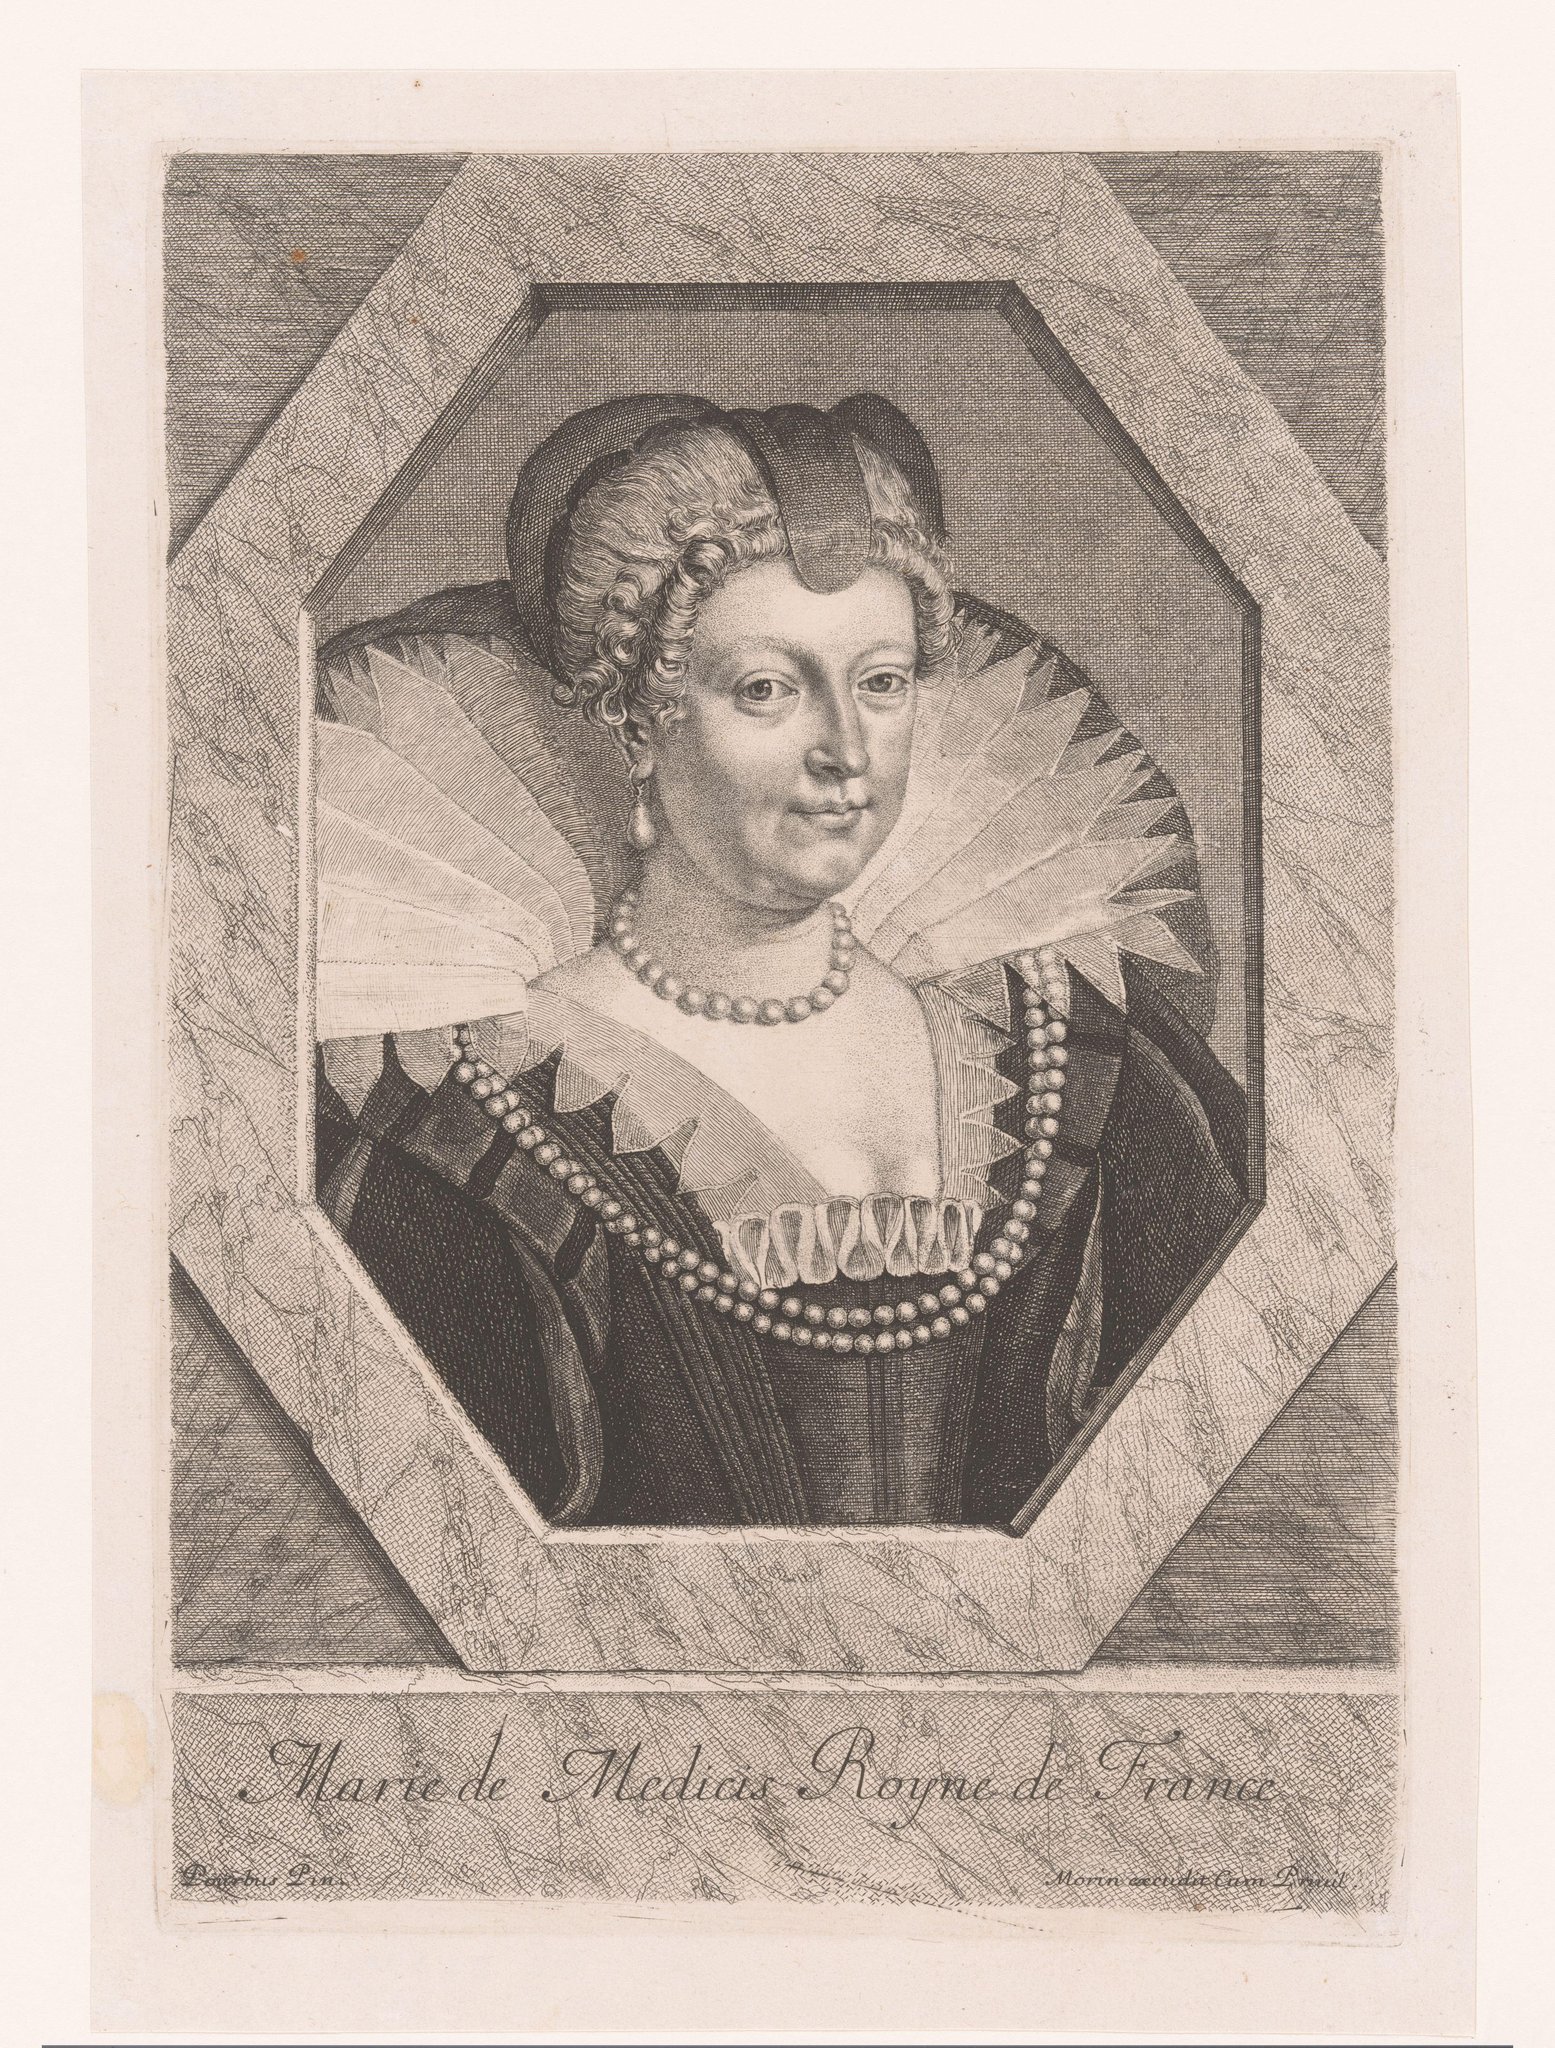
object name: print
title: Portret van Maria de' Medici, koningin van Frankrijk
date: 1650-1660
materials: paper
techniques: etching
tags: print maker, maria de' medici, historical persons, queen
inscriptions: collector's mark: Lugt 2228